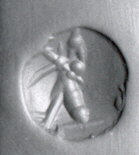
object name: stamp seal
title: Stamp seal (oval conoid) with deity (?)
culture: assyro-babylonian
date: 700-501 BCE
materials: stone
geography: mesopotamia